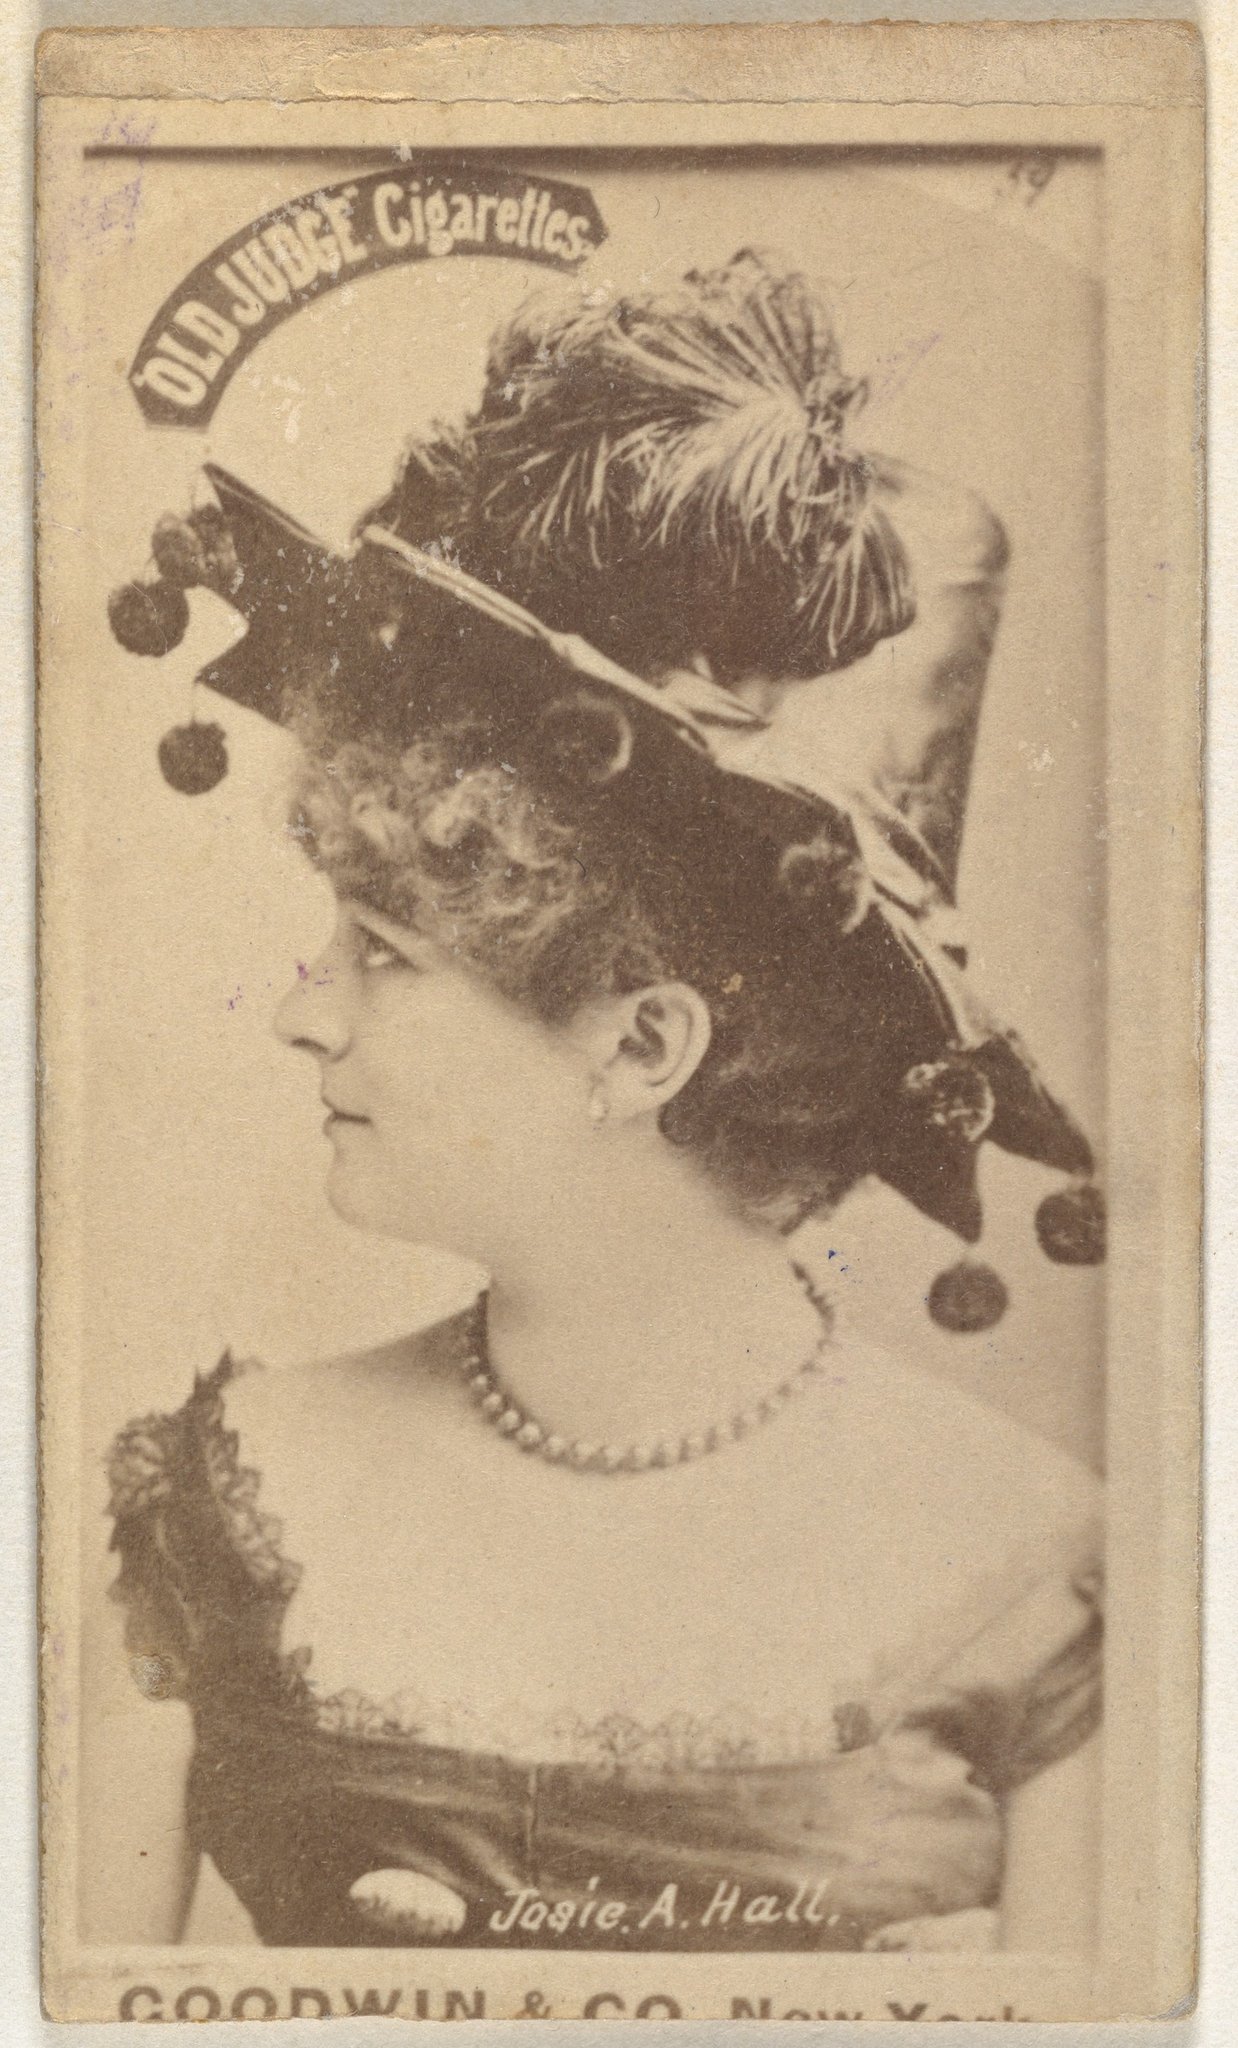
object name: photograph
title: Josie A. Hall, from the Actors and Actresses series (N171) for Old Judge Cigarettes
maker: goodwin & company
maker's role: publisher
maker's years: 1850-1950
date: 1886-1890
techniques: albumen silver print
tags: portraits,women,actresses